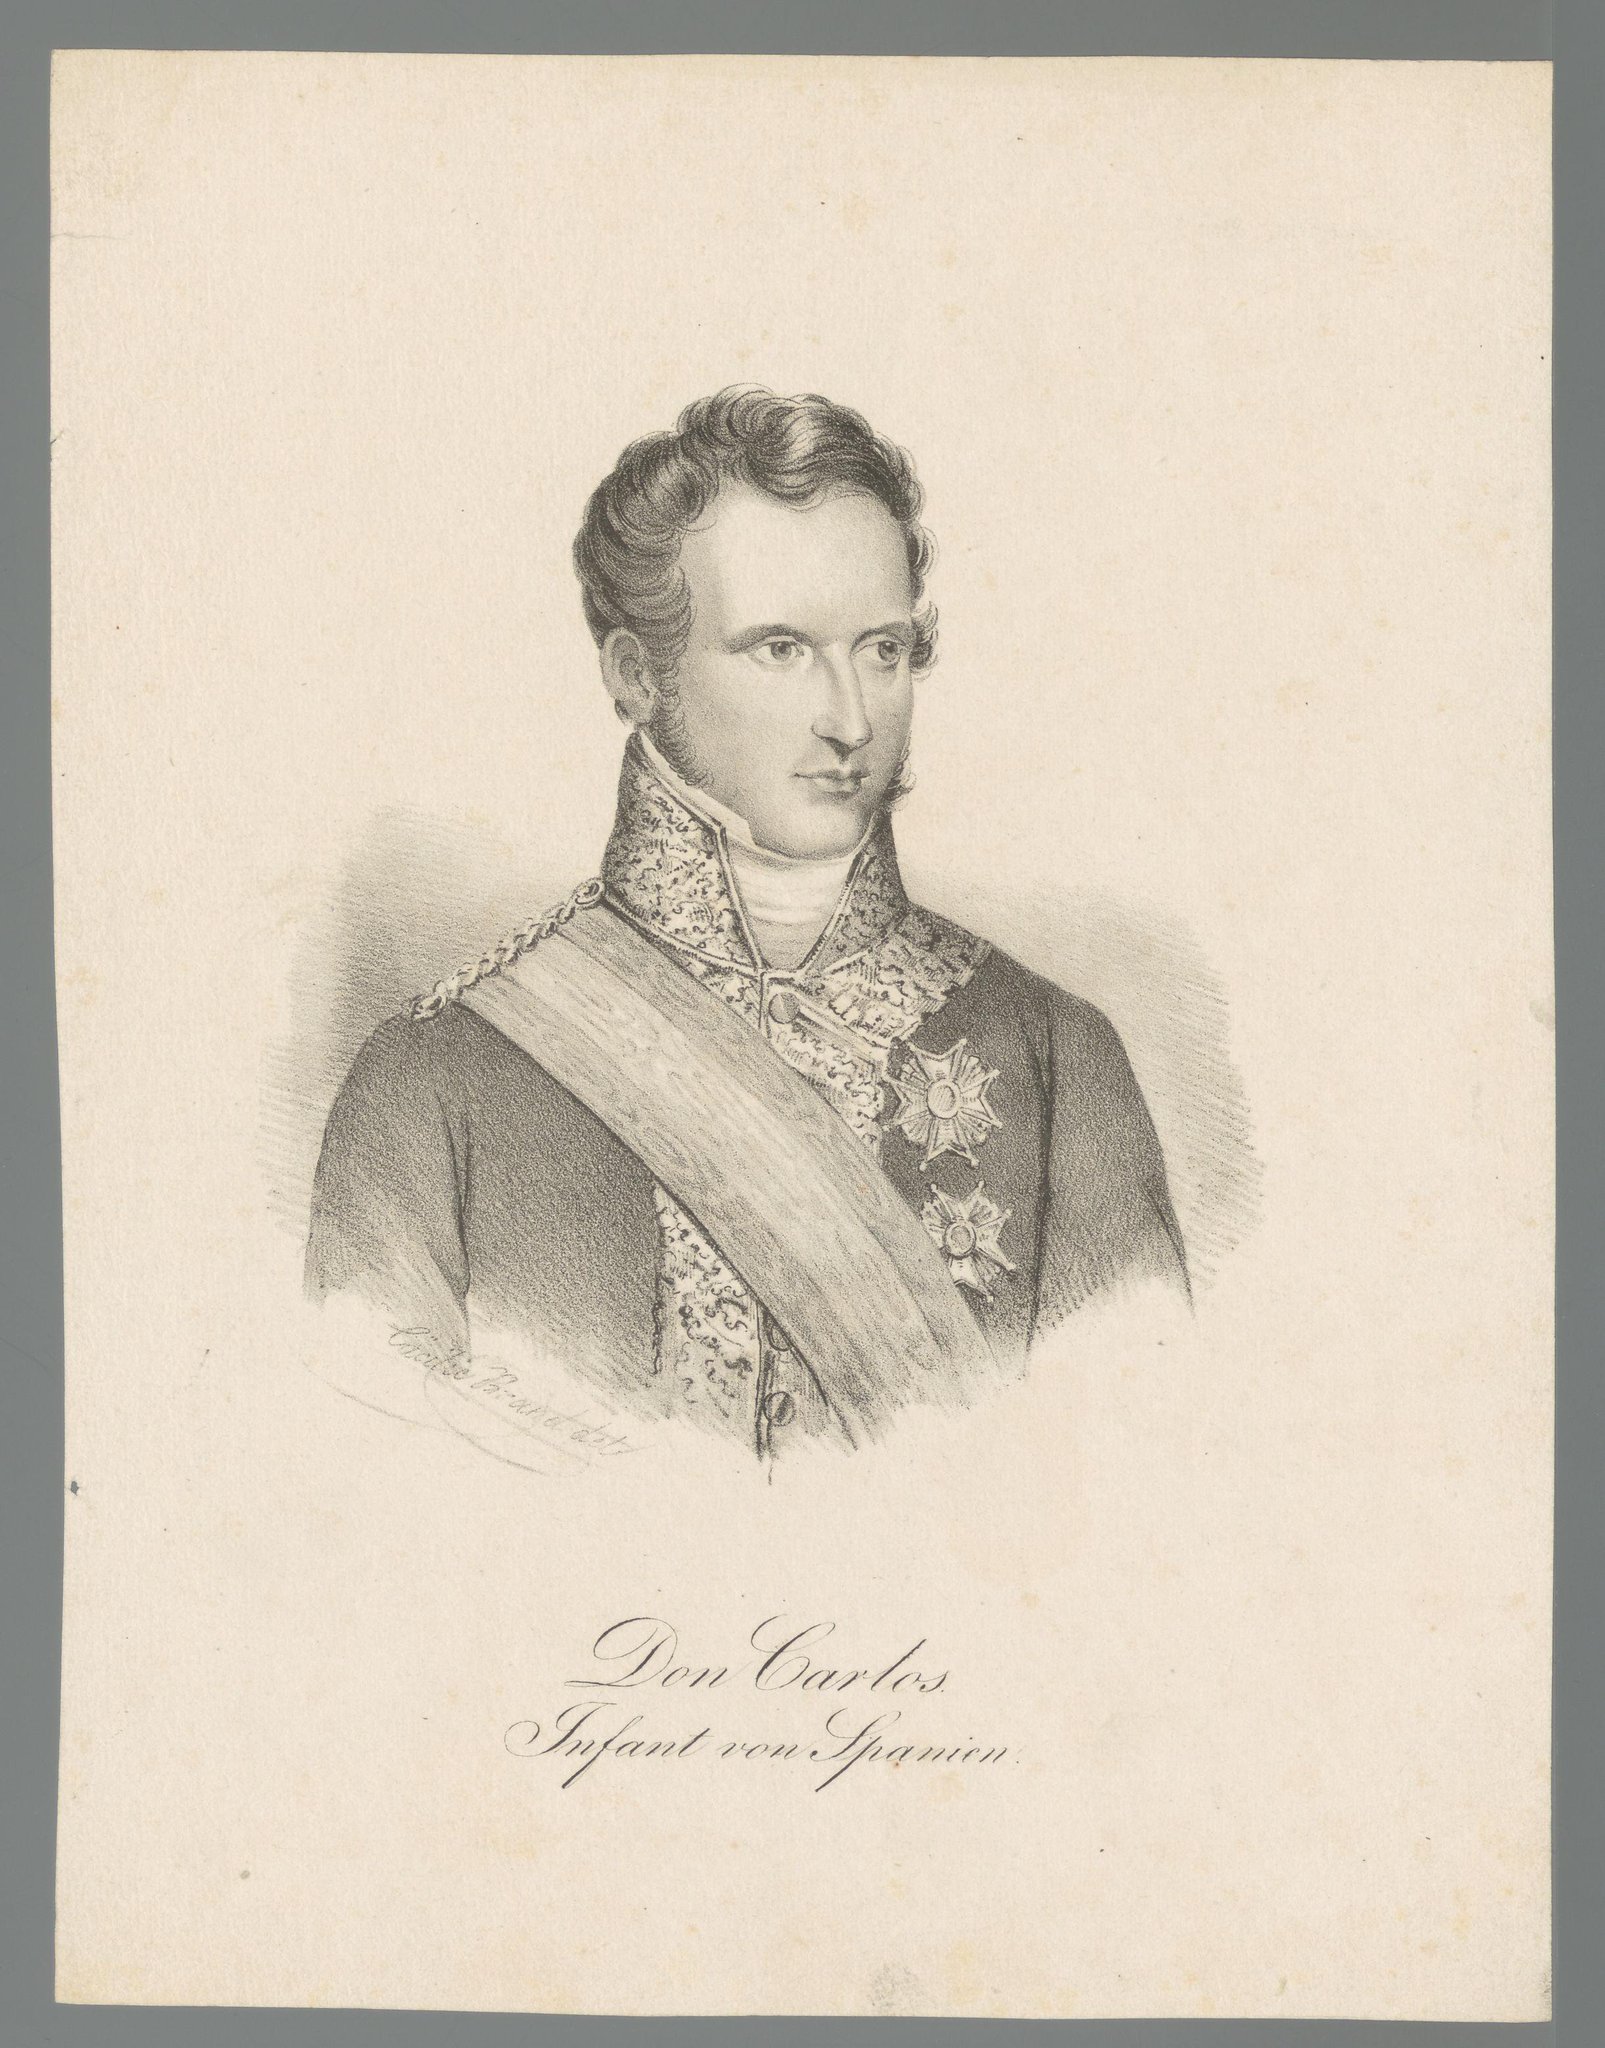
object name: print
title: Portret van Carlos María Isidro Benito de Bórbon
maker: cäcilie brandt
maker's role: print maker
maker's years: 1814-1852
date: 1825-1850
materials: paper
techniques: lithograph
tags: earl, adult man, historical persons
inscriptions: collector's mark: Lugt 2228